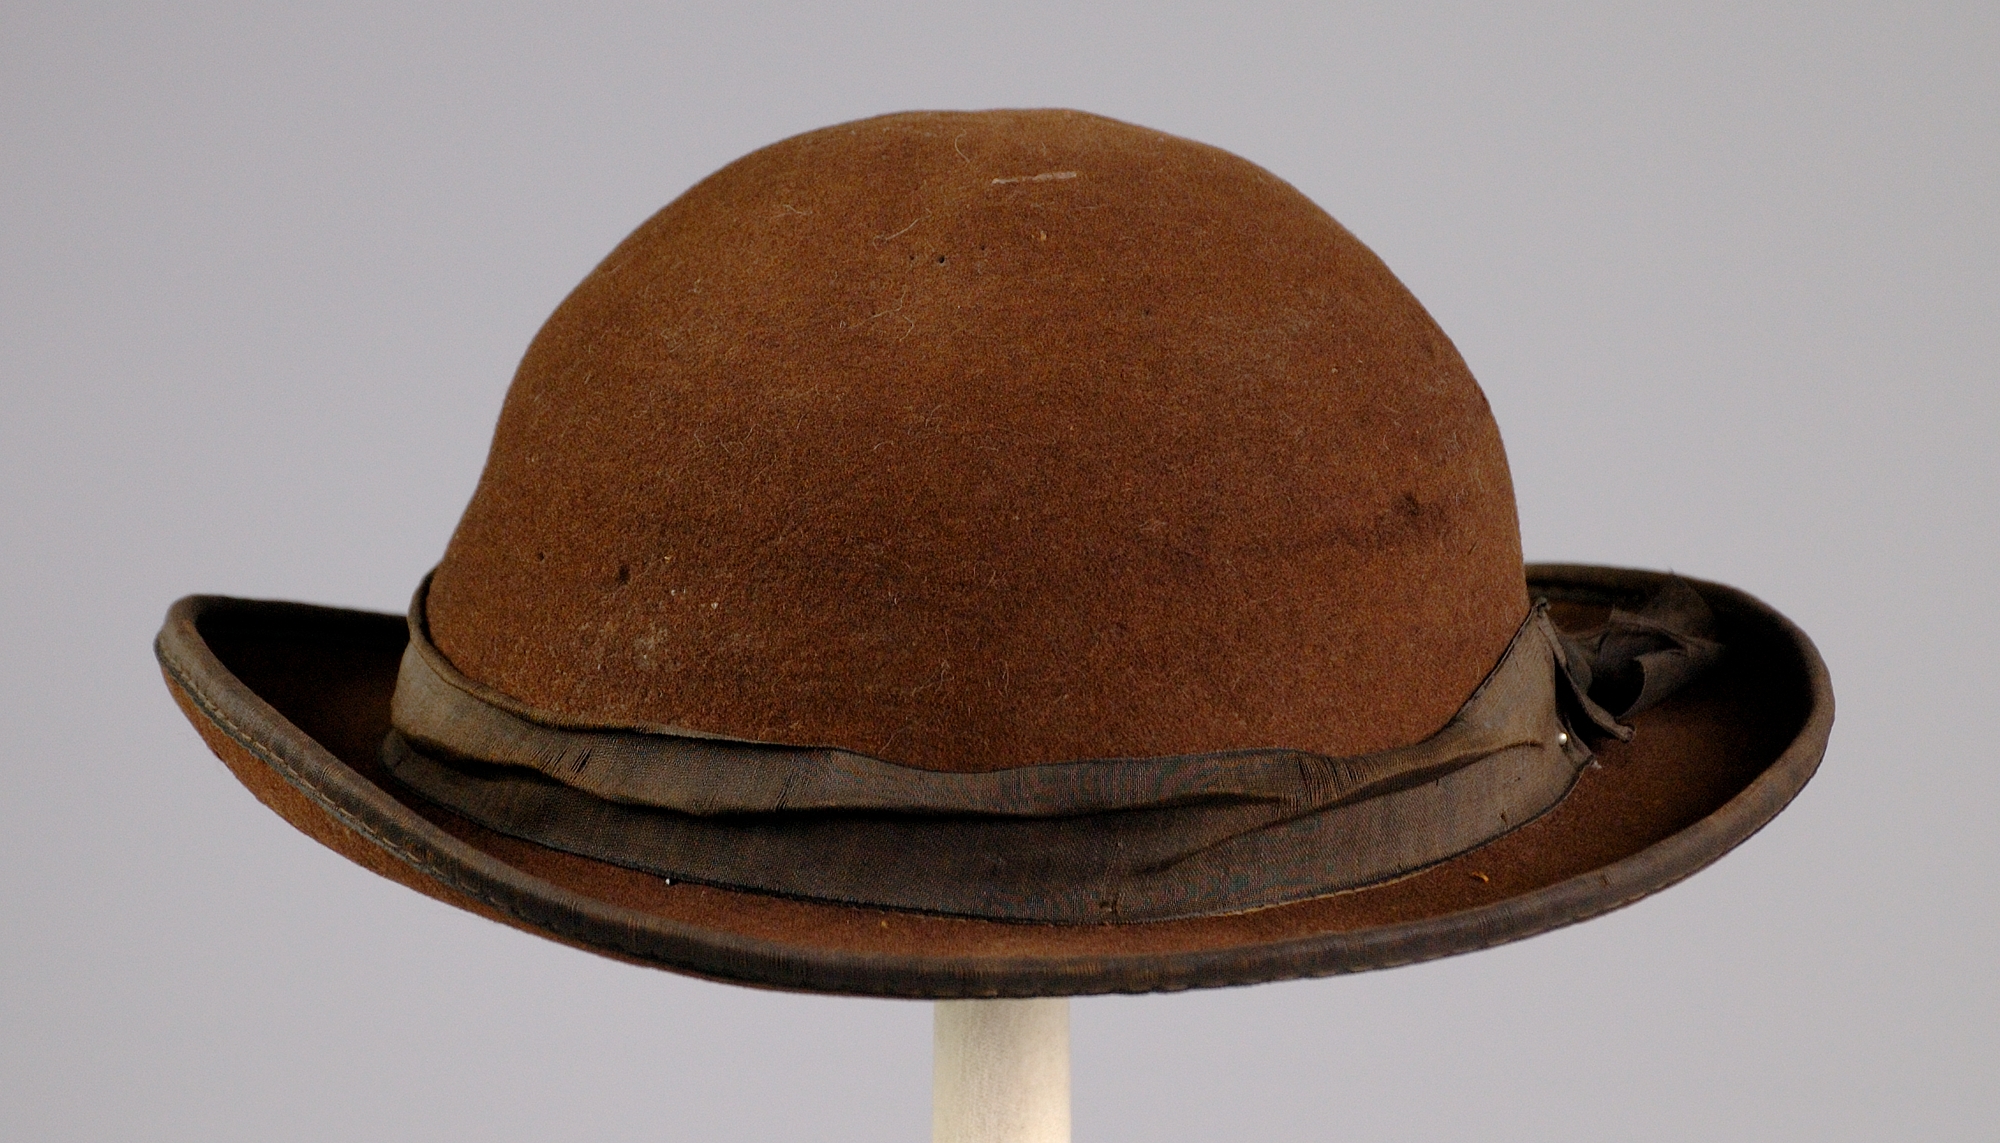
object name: hat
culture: american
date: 1870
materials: silk, wool